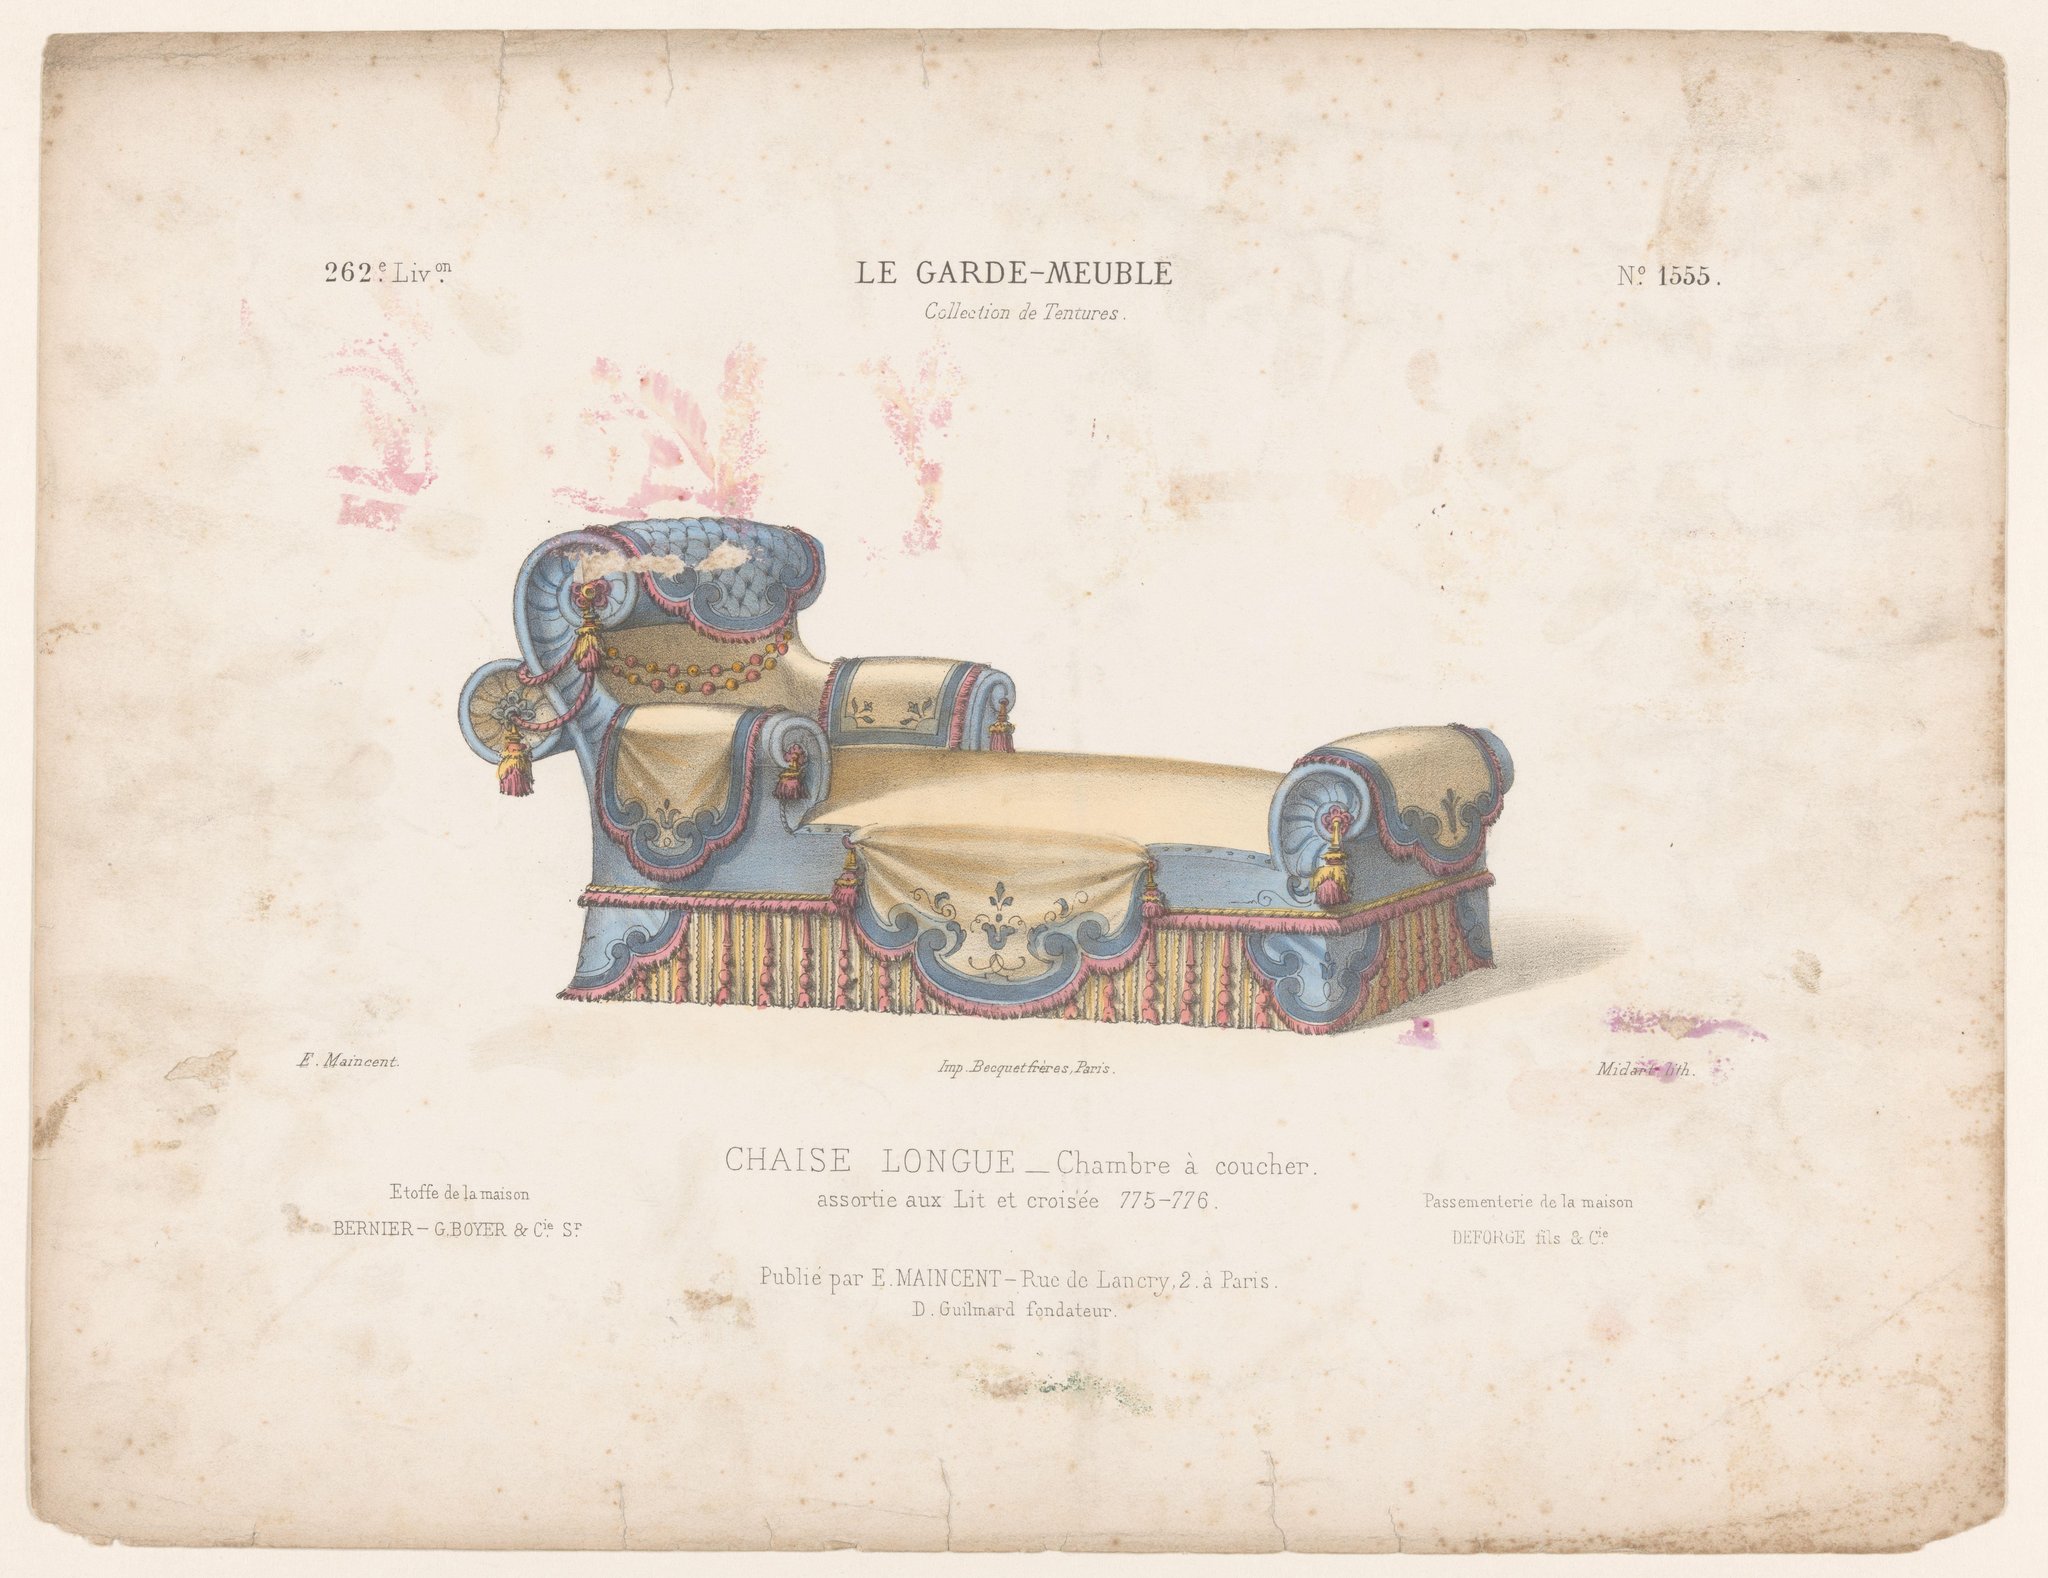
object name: print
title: Ligstoel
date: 1885-1895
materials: paper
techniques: hand coloring, lithograph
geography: paris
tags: armchair, seat, hangings and drapery, bedroom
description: Chaise longue voor de slaapkamer. Prent uit 262e Livraison.